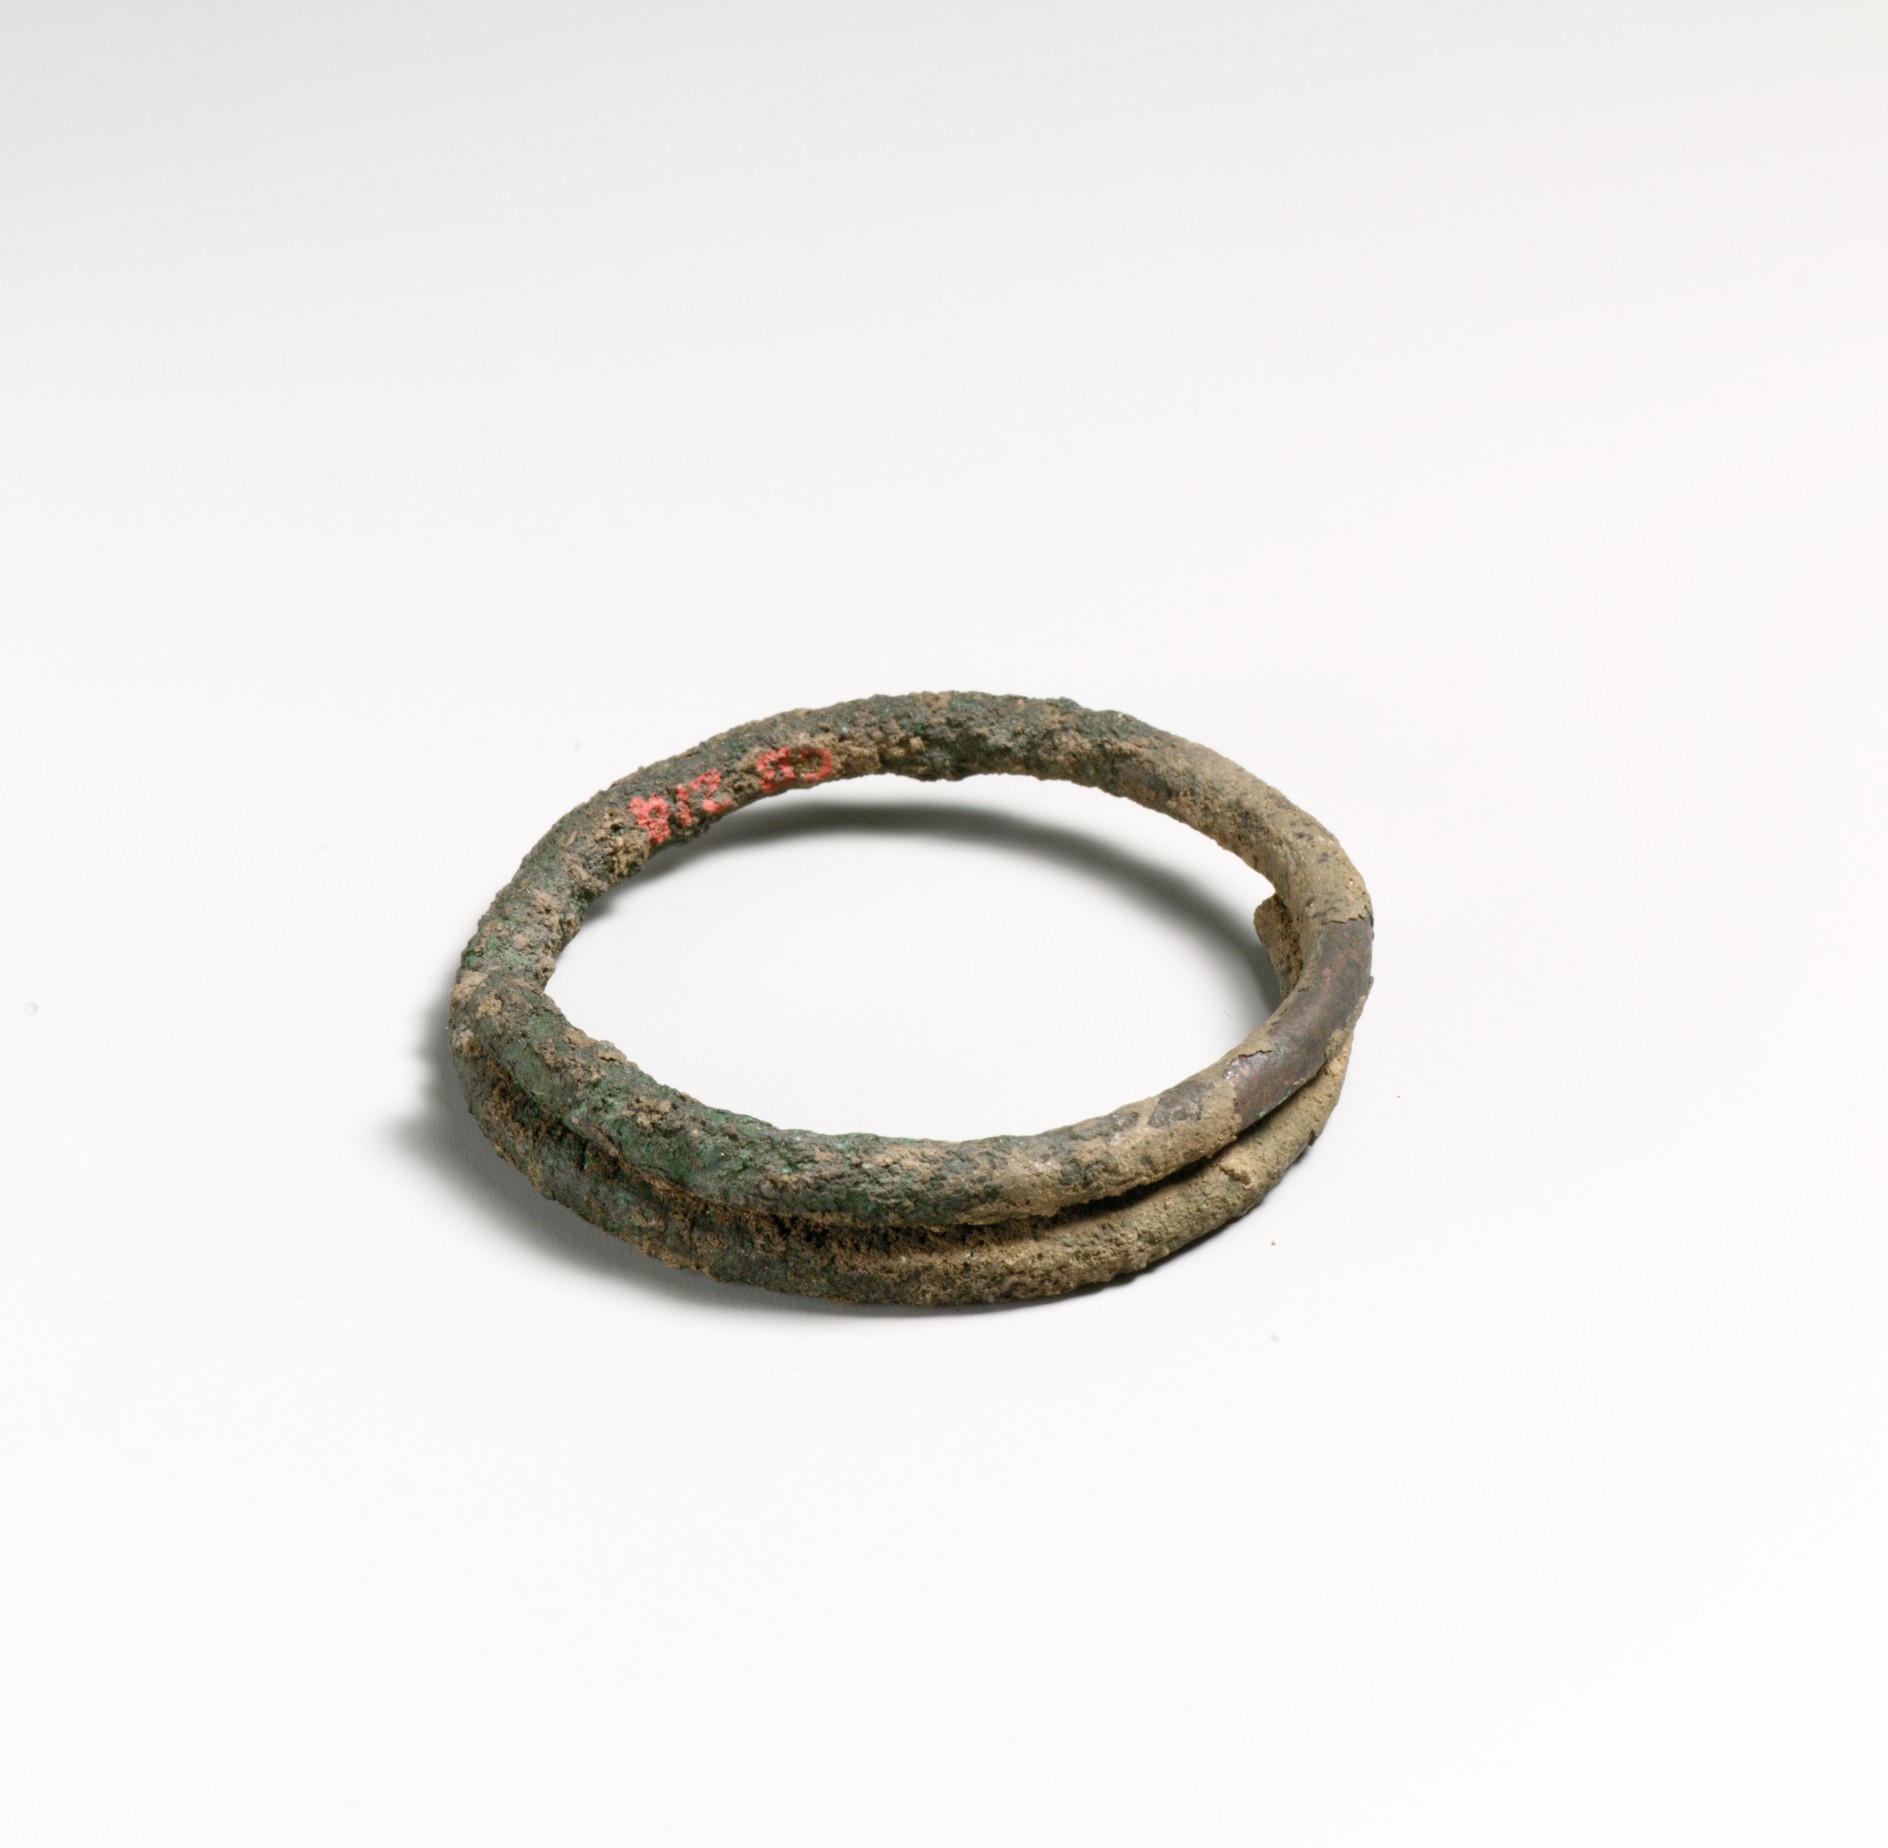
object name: bracelet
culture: cypriot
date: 3900 BCE-100 CE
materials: bronze